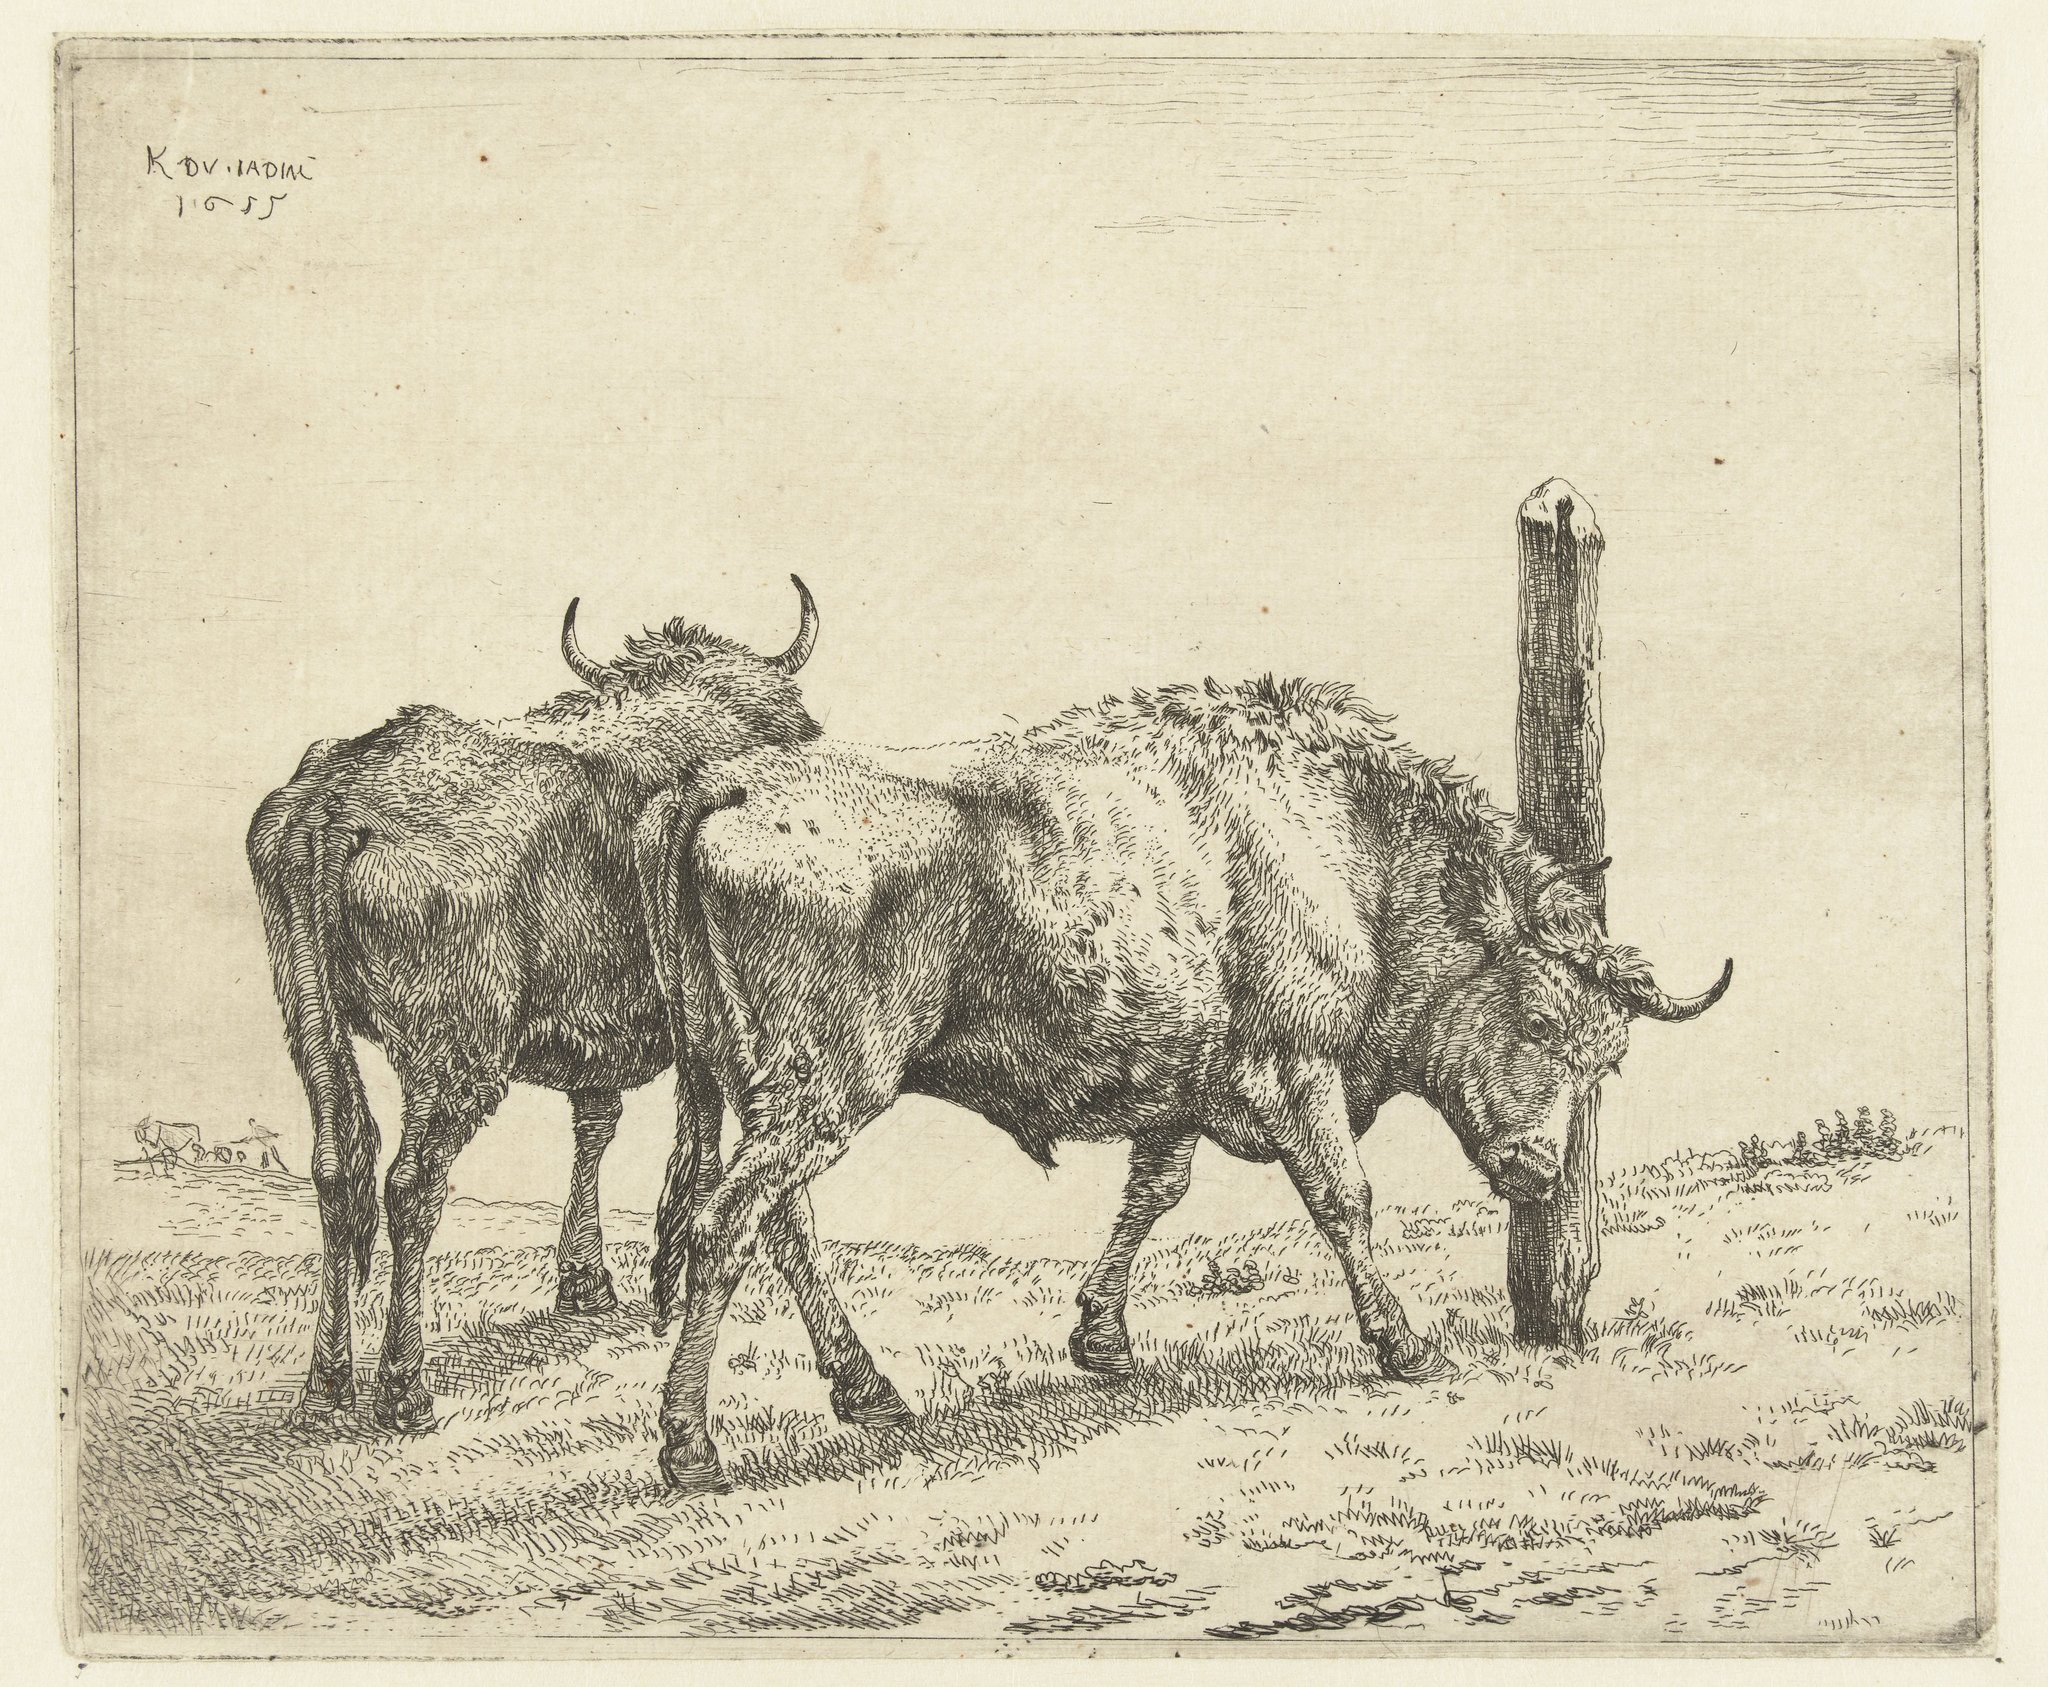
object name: print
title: Twee ossen, één schuurt de kop tegen een paal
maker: karel du jardin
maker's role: draughtsman, painter, print maker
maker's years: 1626-1678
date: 1655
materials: paper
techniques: etching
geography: amsterdam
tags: ox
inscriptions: collector's mark: Lugt 240